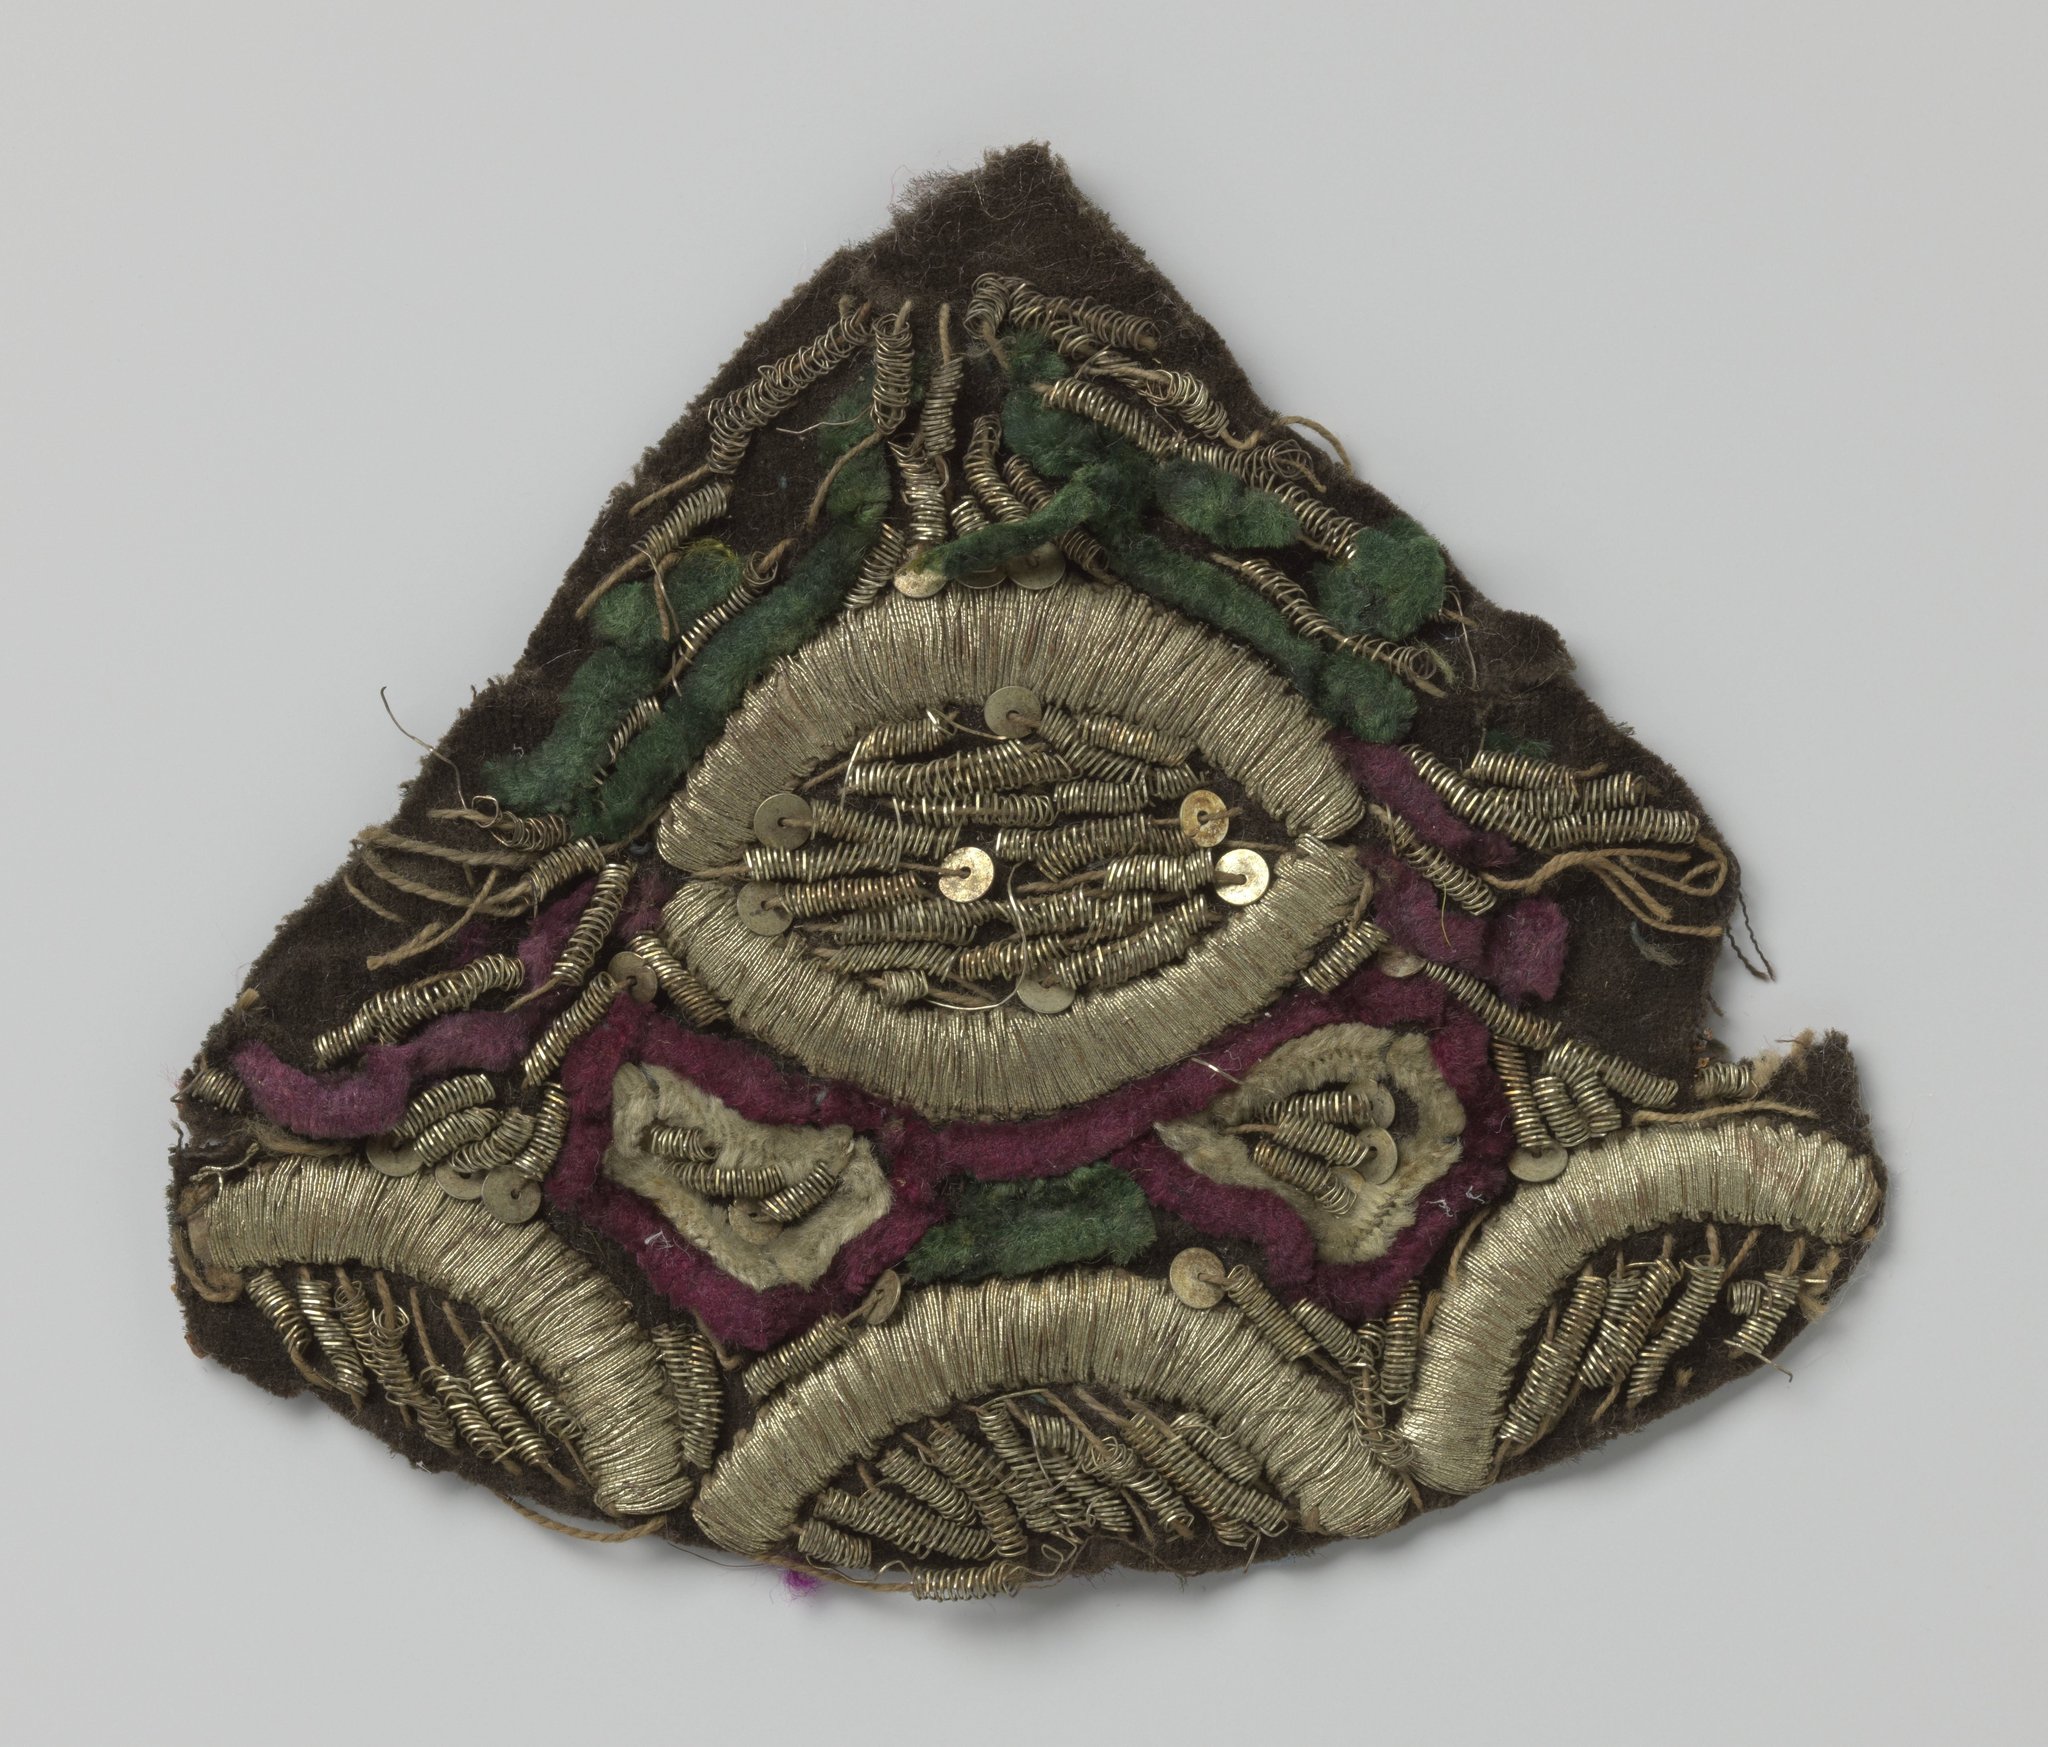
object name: zijdefluweel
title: Fragment fluweel met veelkleurig borduurwerk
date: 1650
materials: linen, silk, velvet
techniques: embroidered, weave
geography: germany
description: Fragment fluweel met veelkleurig borduurwerk. Het fragment is driehoekig en heeft langs een zijde drie halve cirkels van zilverkleurig garen. In het midden is een ovaal in zilverkleur geborduurd.